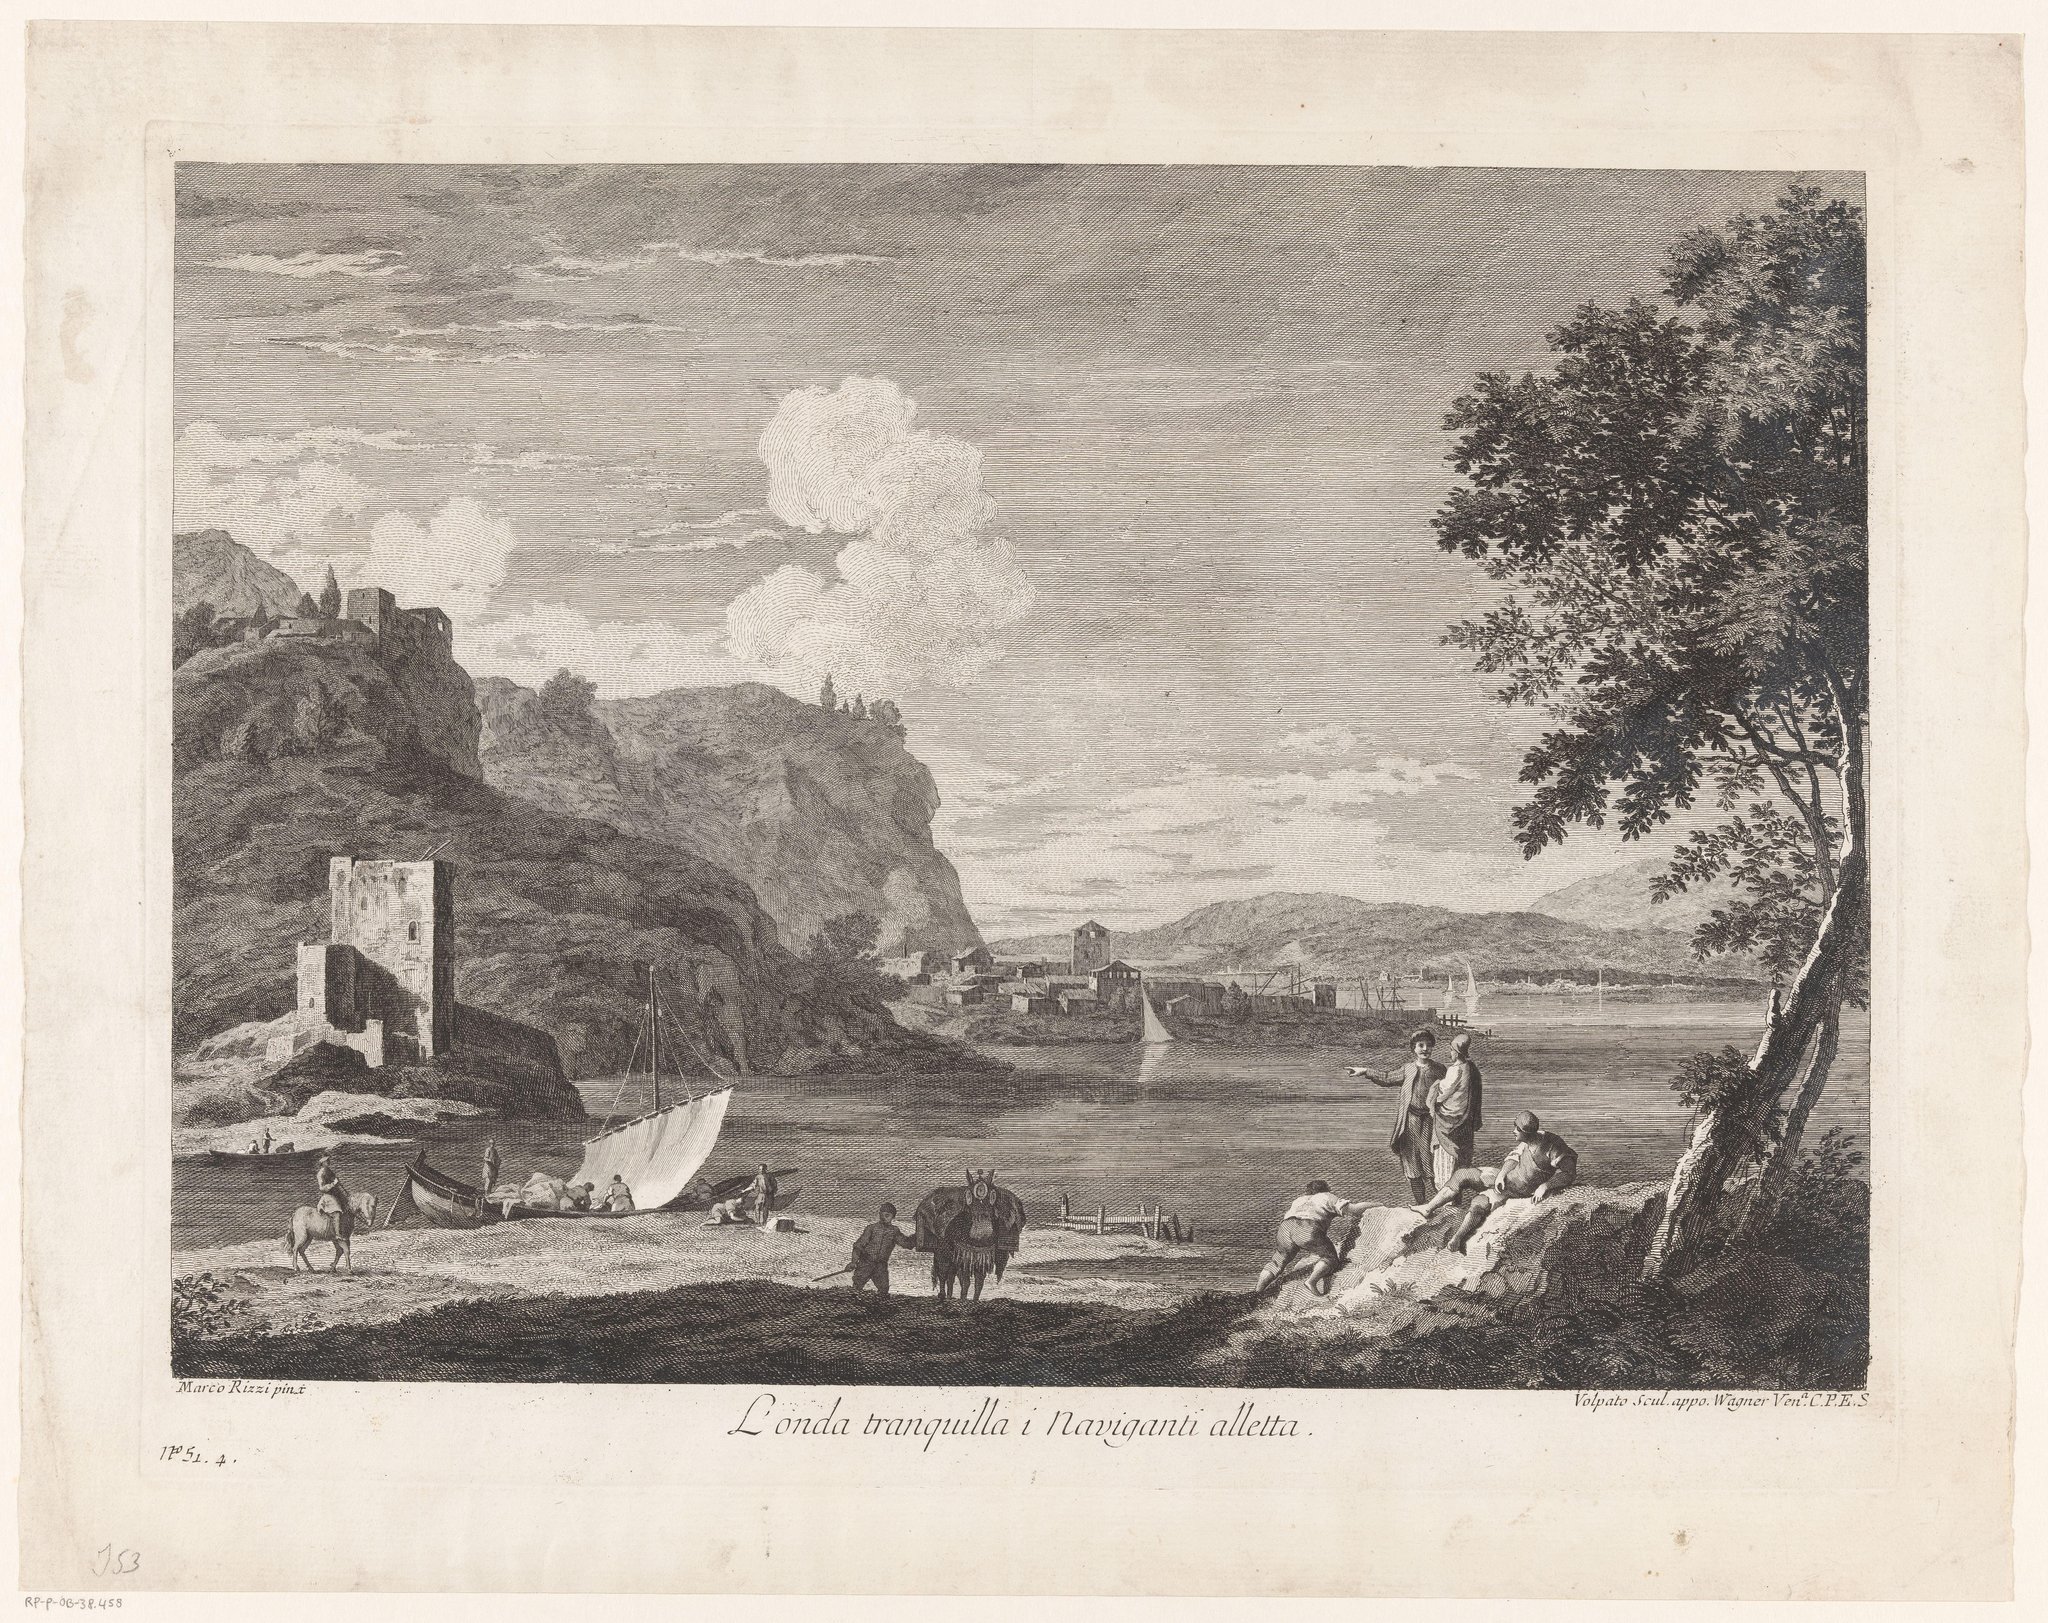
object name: print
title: Rivierlandschap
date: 1750-1803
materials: paper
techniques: etching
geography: italy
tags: city-view, and landscape with man-made constructions, river, landscape with ruins, mule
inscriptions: collector's mark: Lugt 2228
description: Een rivierlandschap met links een ruïne en op de voorgrond een aangemeerde boot en een man met een pakezel. Genummerd linksonder: No 51. 4. Titel in ondermarge.